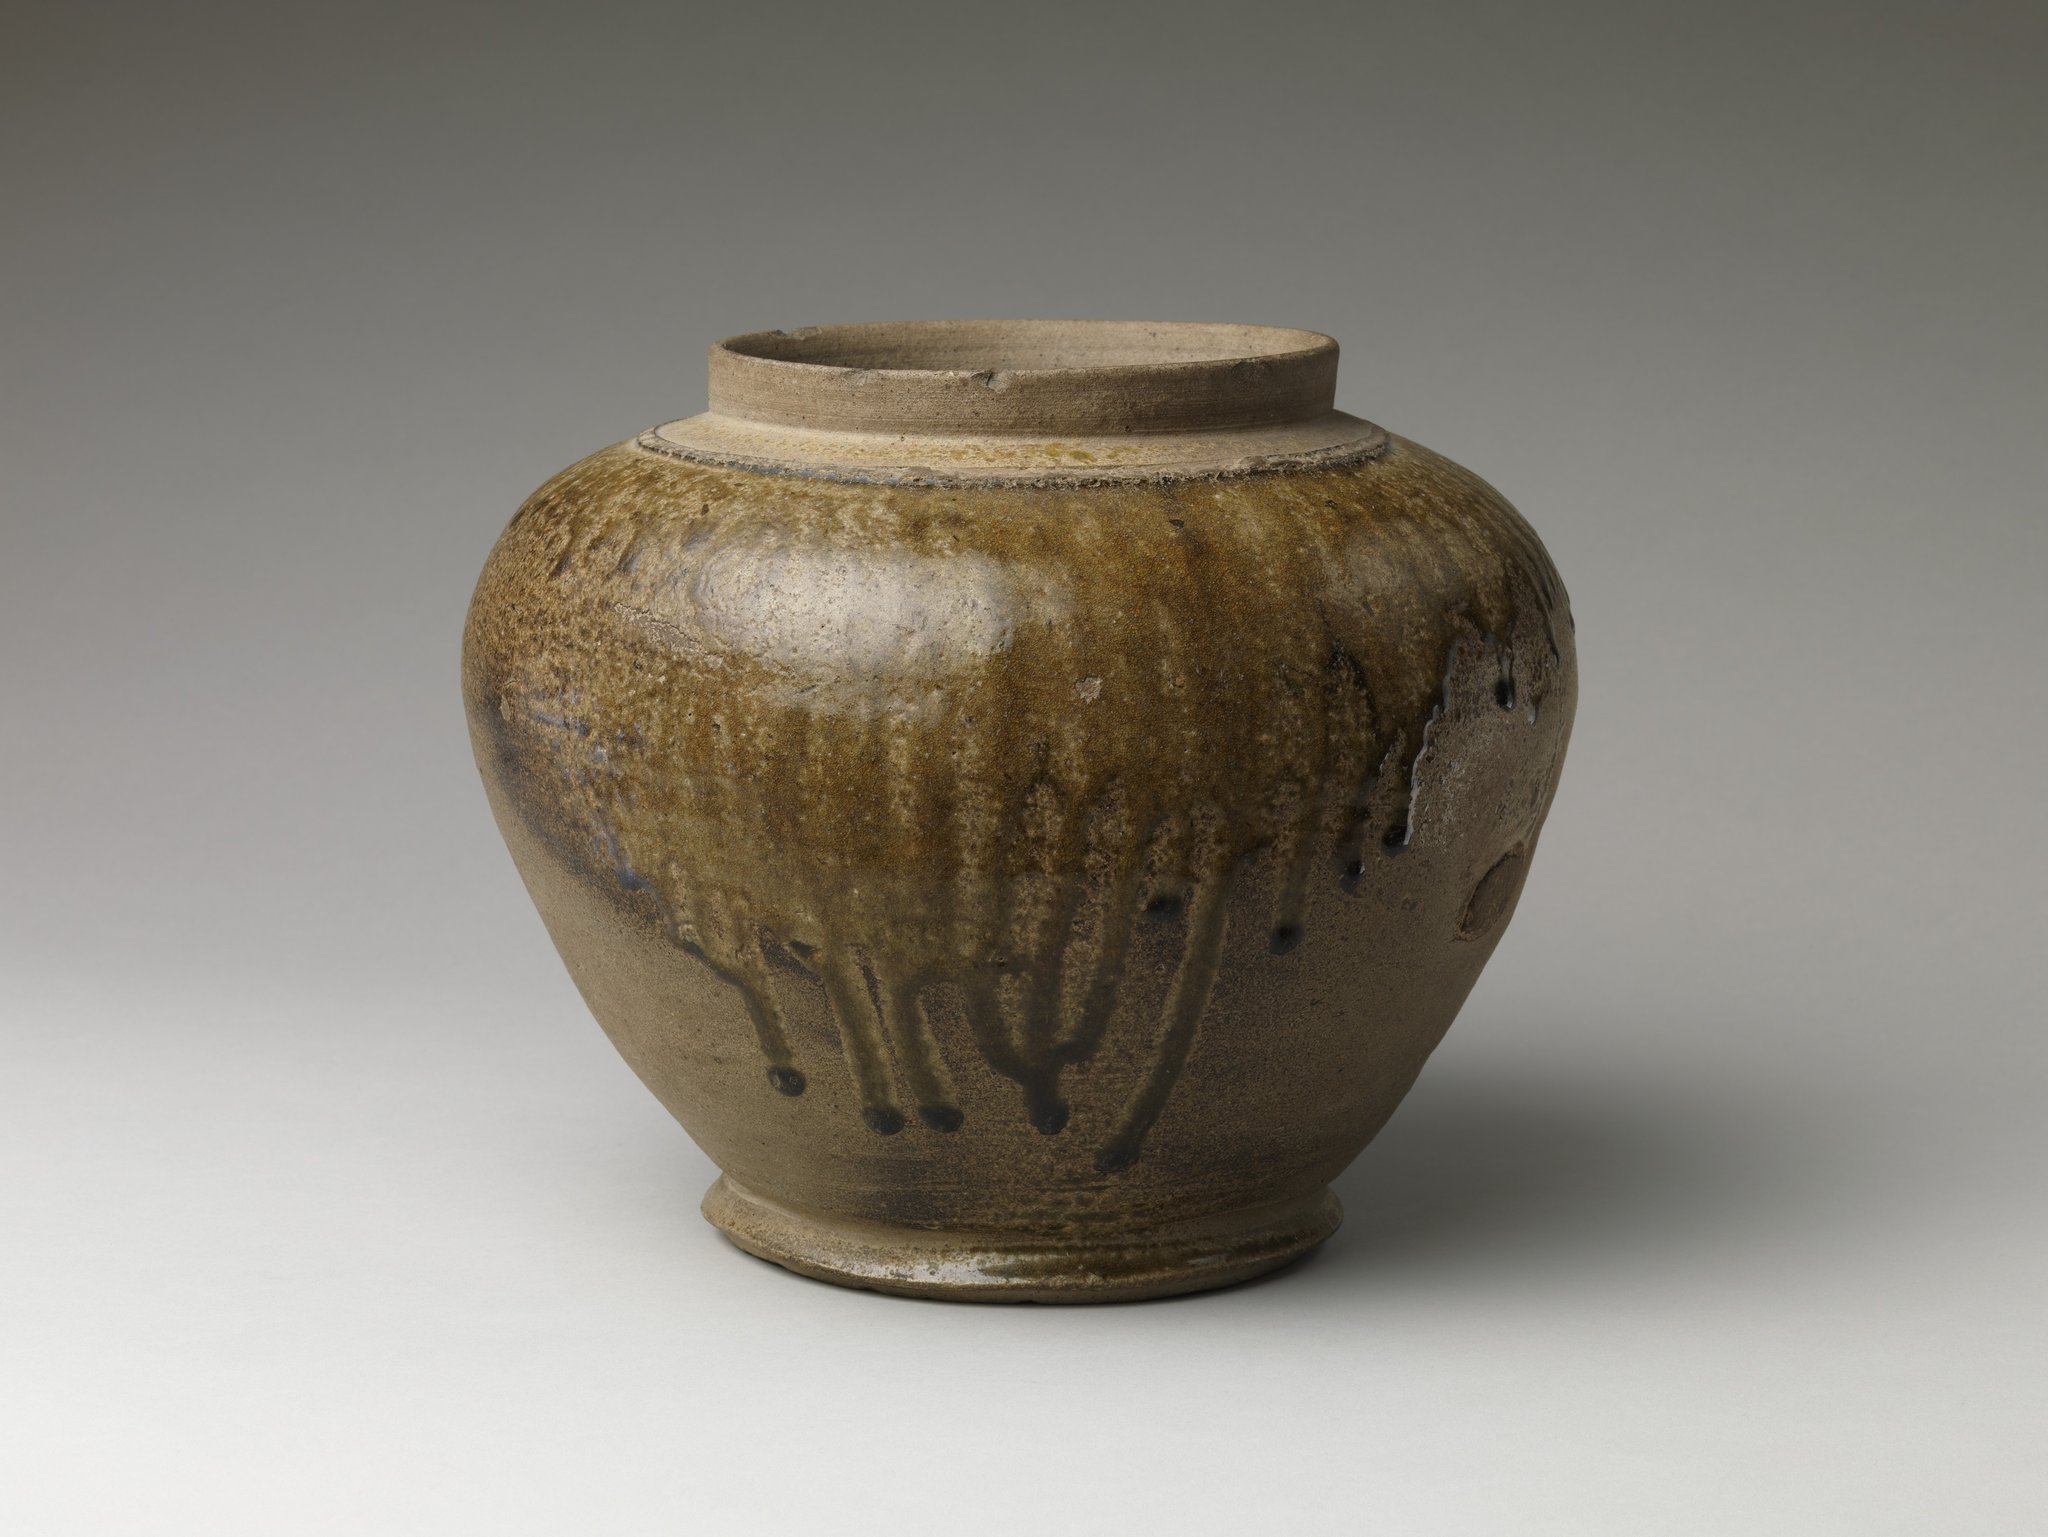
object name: urn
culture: japanese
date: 701-800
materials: wood, glaze, stoneware